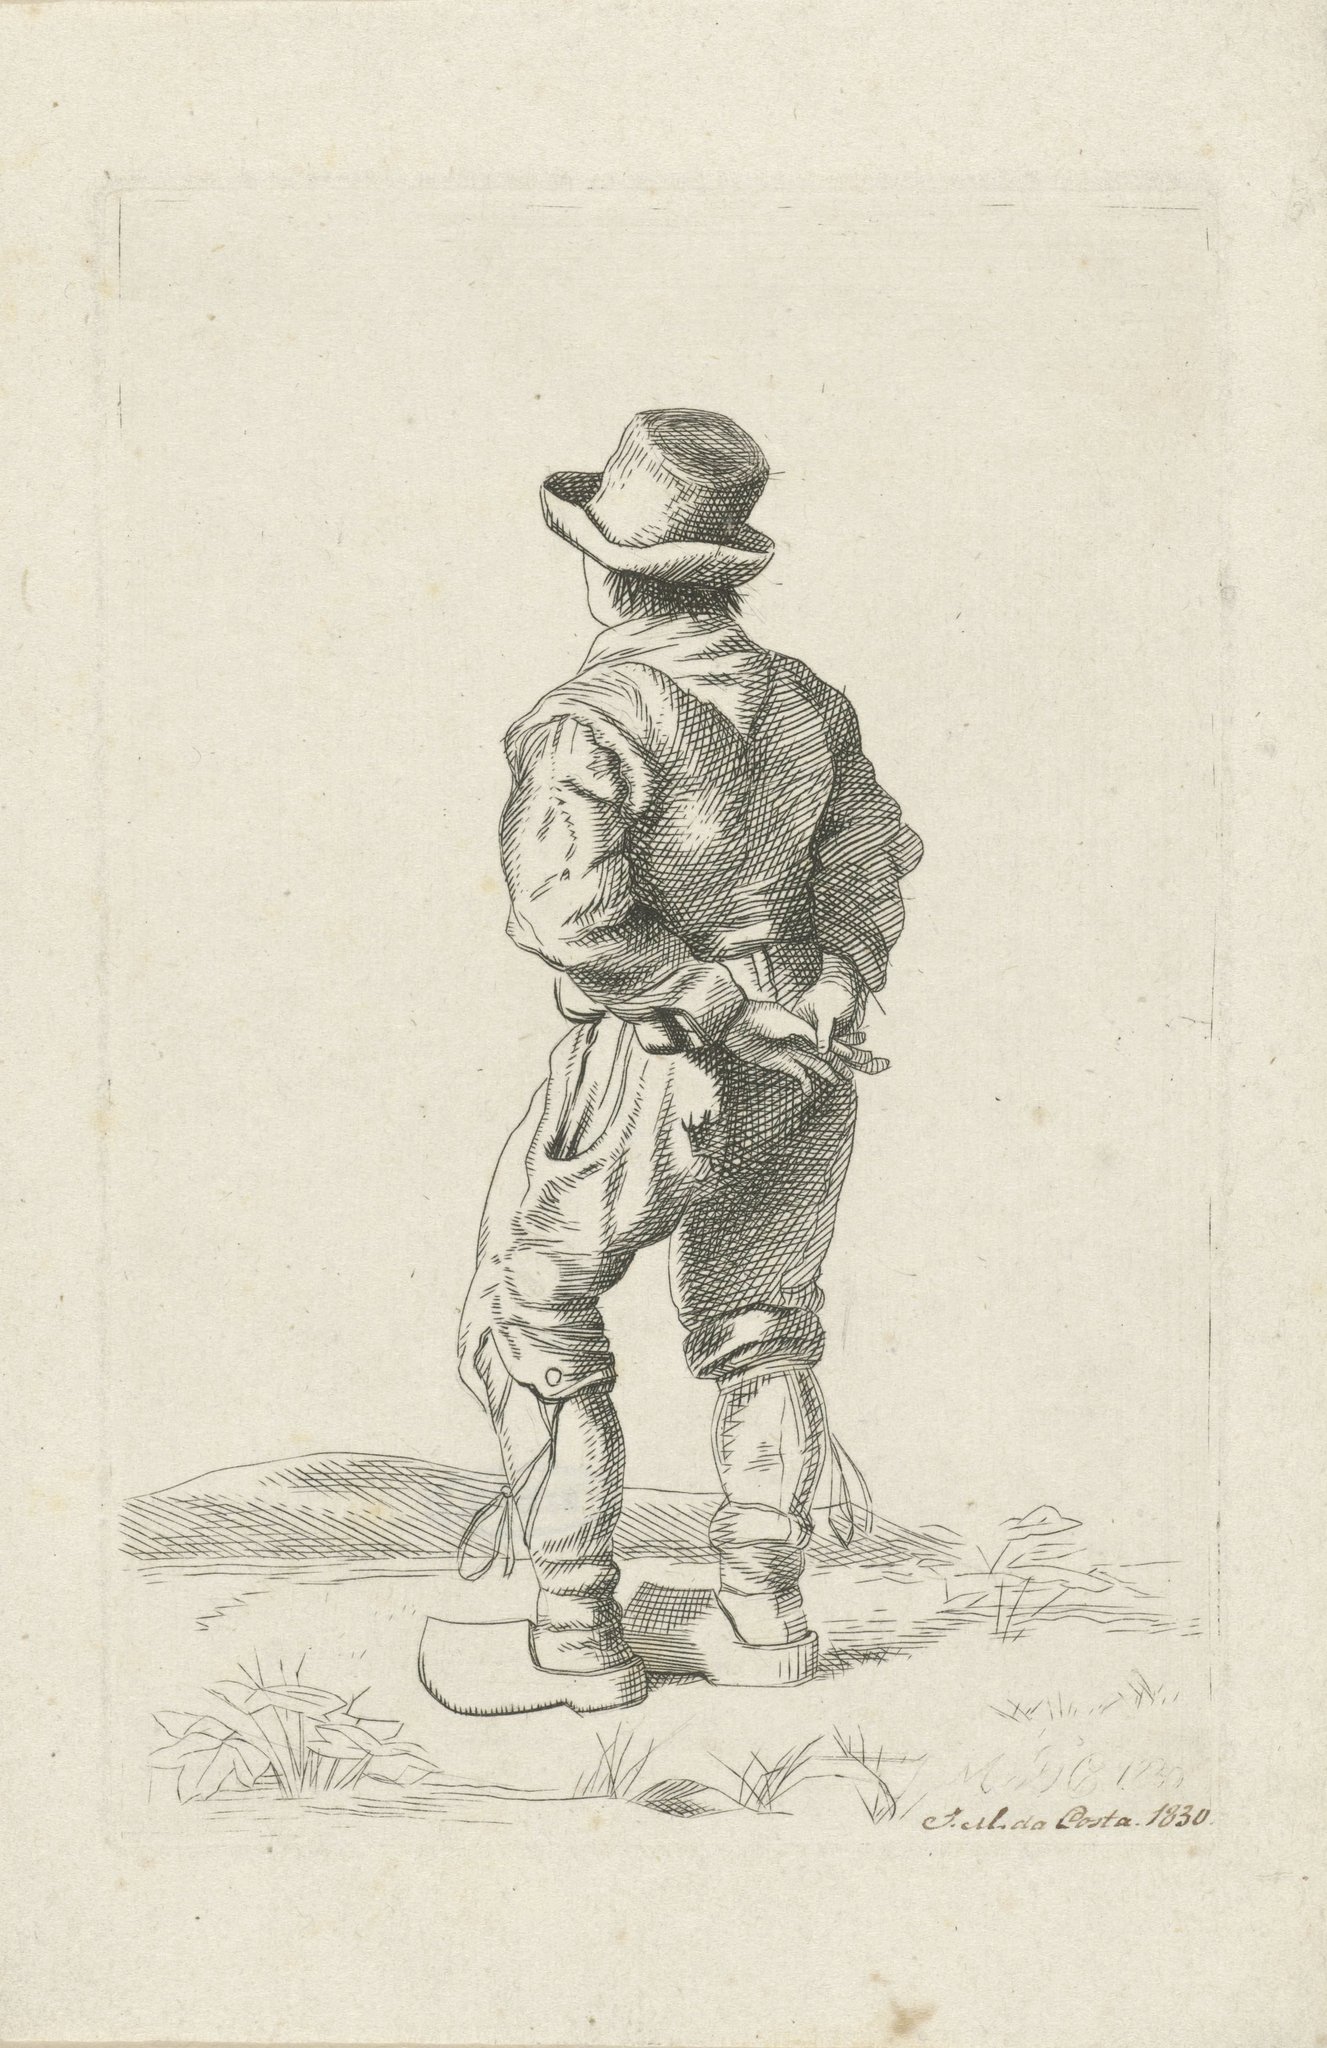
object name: print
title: Studie van een boerenjongen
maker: joseph mendes da costa (1806-1893)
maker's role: draughtsman, print maker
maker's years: 1806-1893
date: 1830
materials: paper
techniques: engraving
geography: amsterdam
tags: wooden shoes, clogs, farmers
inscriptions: collector's mark: Lugt 2760, signature: ‘J.M. da Costa 1830’, collector's mark: Lugt 2228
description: Studie van een boerenjongen, op de rug gezien, met hoed en klompen.